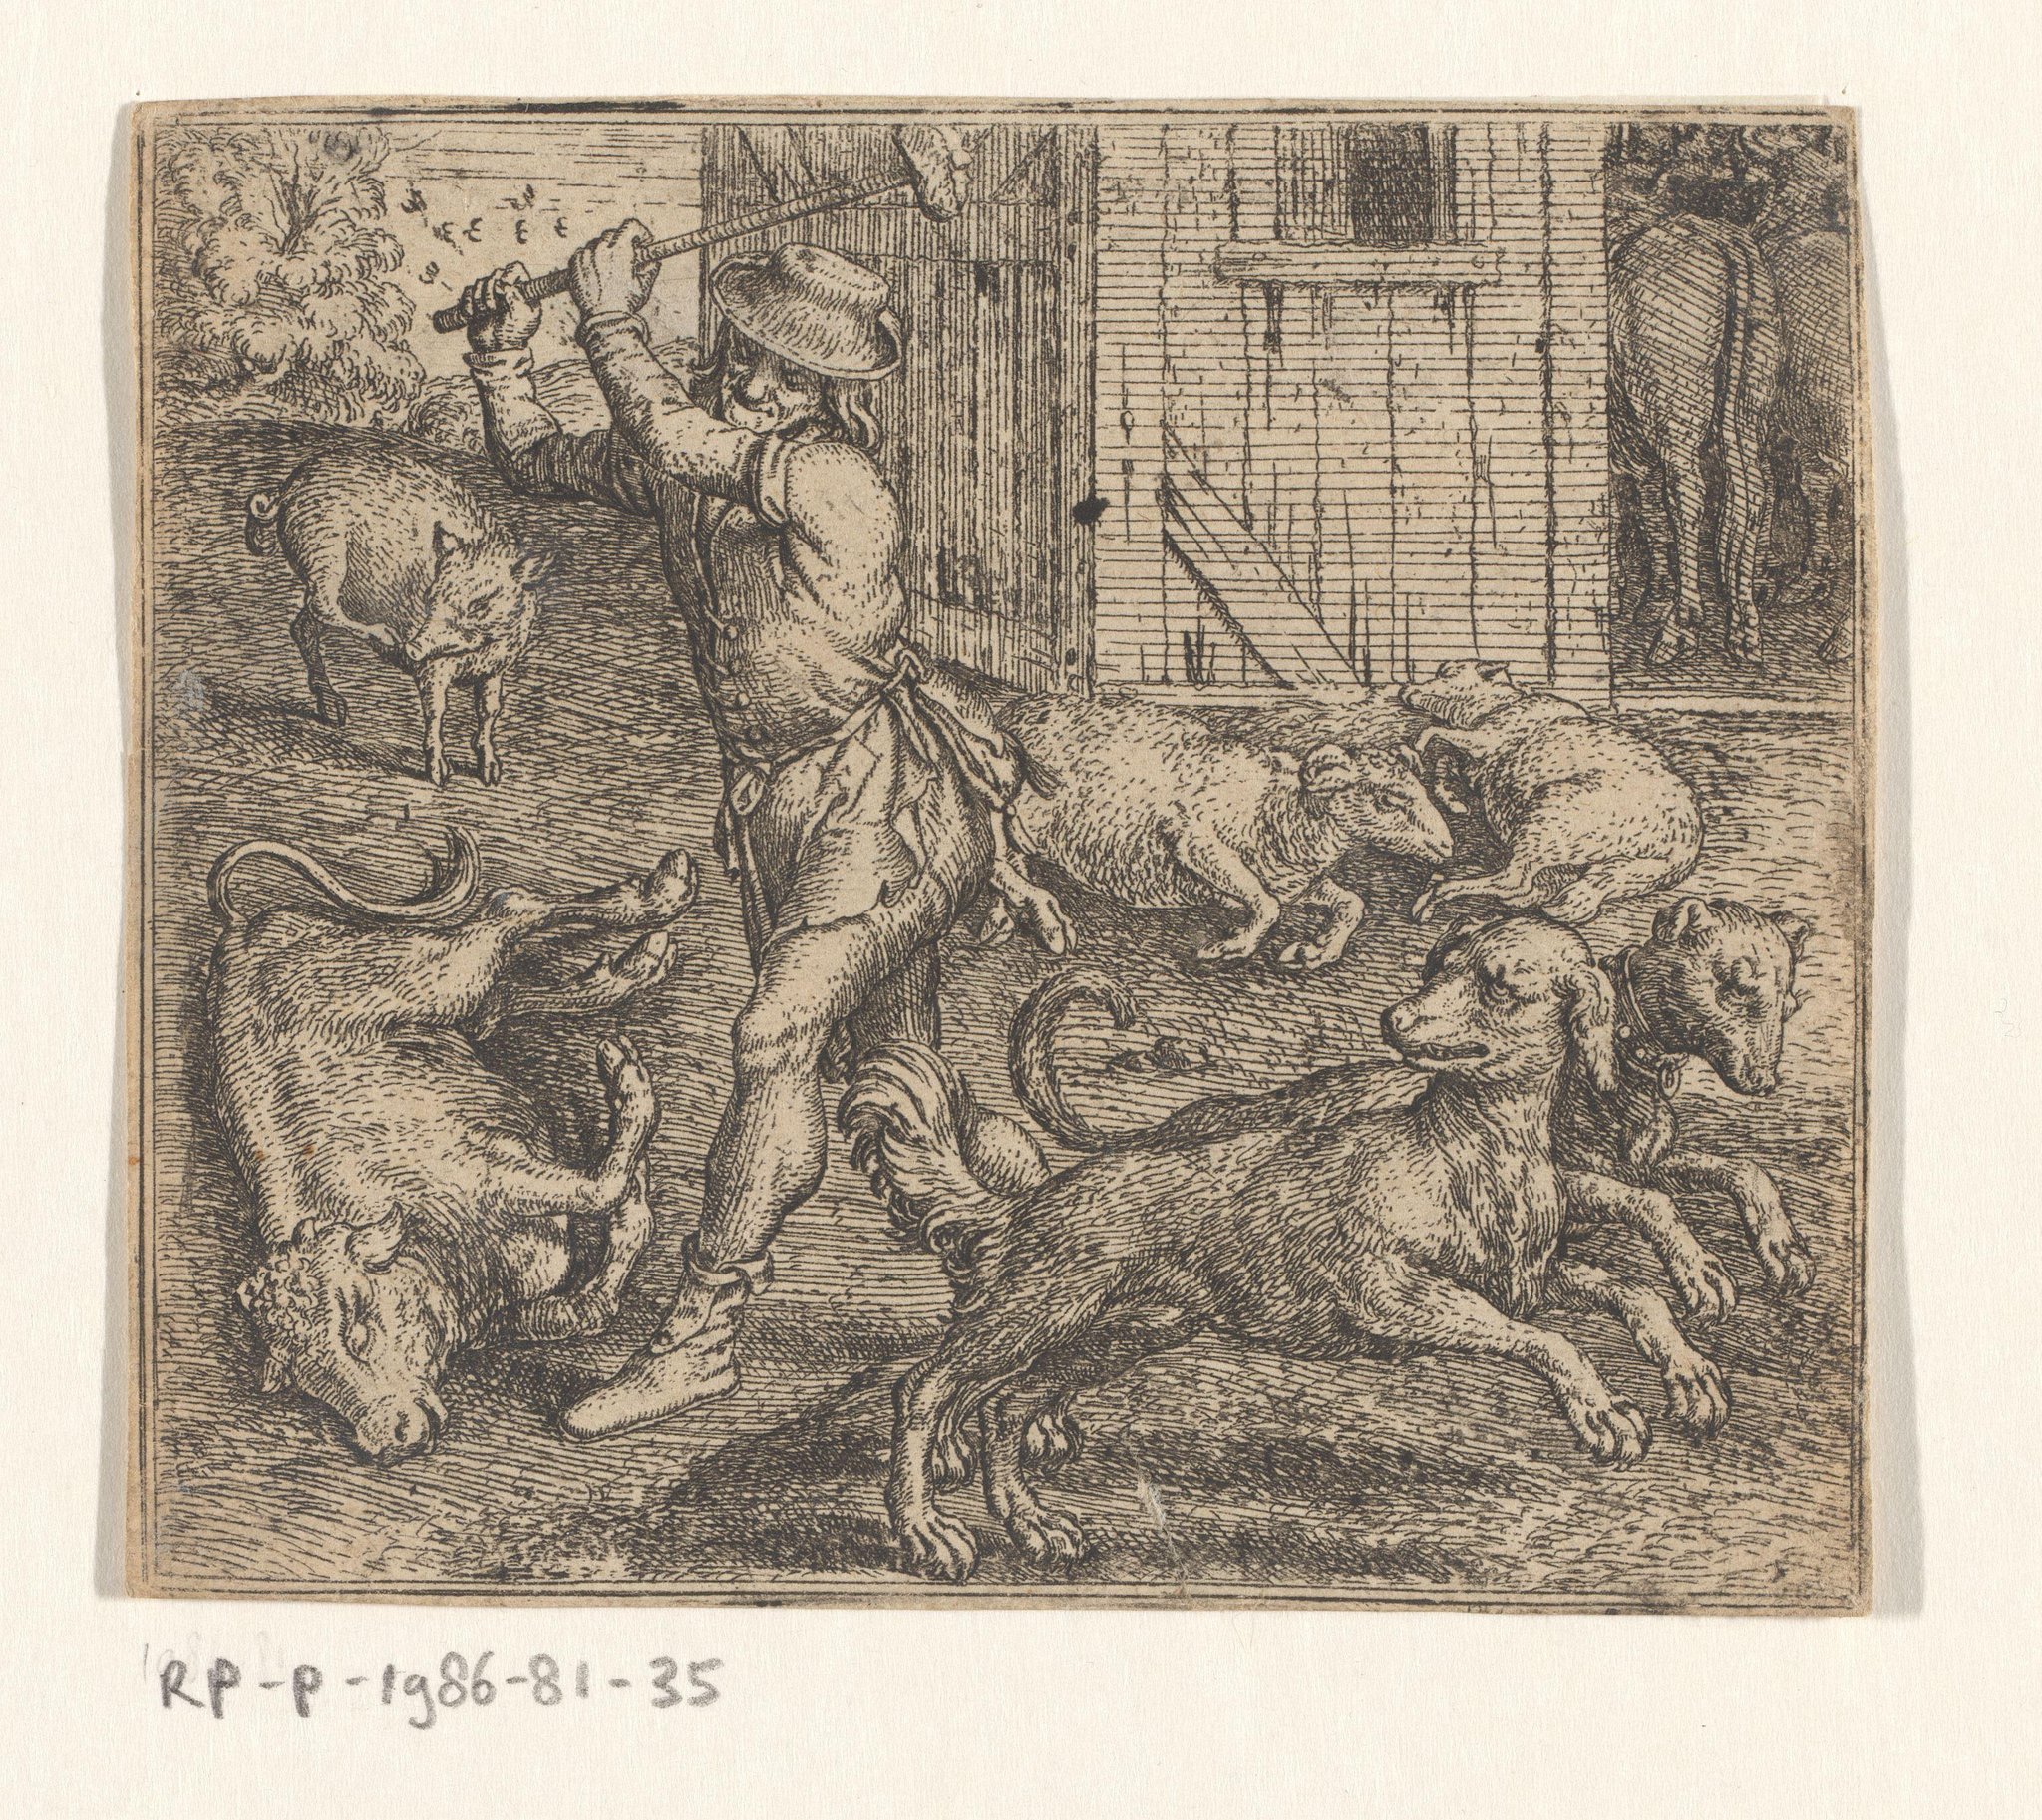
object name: print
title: Fabel van de boer en zijn honden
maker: marcus gheeraerts (i)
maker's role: draughtsman, painter, print maker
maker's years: 1520-1590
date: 1567-1617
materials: paper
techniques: etching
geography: bruges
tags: farmers, fables of aesop : use 85(...), stall, stable, man killing animal, dog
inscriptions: collector's mark: Lugt 2228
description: De prent is met tekst op verso gebruikt in: Dene, Eduard de. De warachtighe fabulen der dieren. Brugge: Pieter de Clerck, 1567. De prent is vermoedelijk daarna nog gebruikt in andere publicaties uit 1579 en 1617. Zie Hollstein. Mogelijk is deze prent ook nog gebruikt in 'Vorstelijcke warande der dieren', 1682.